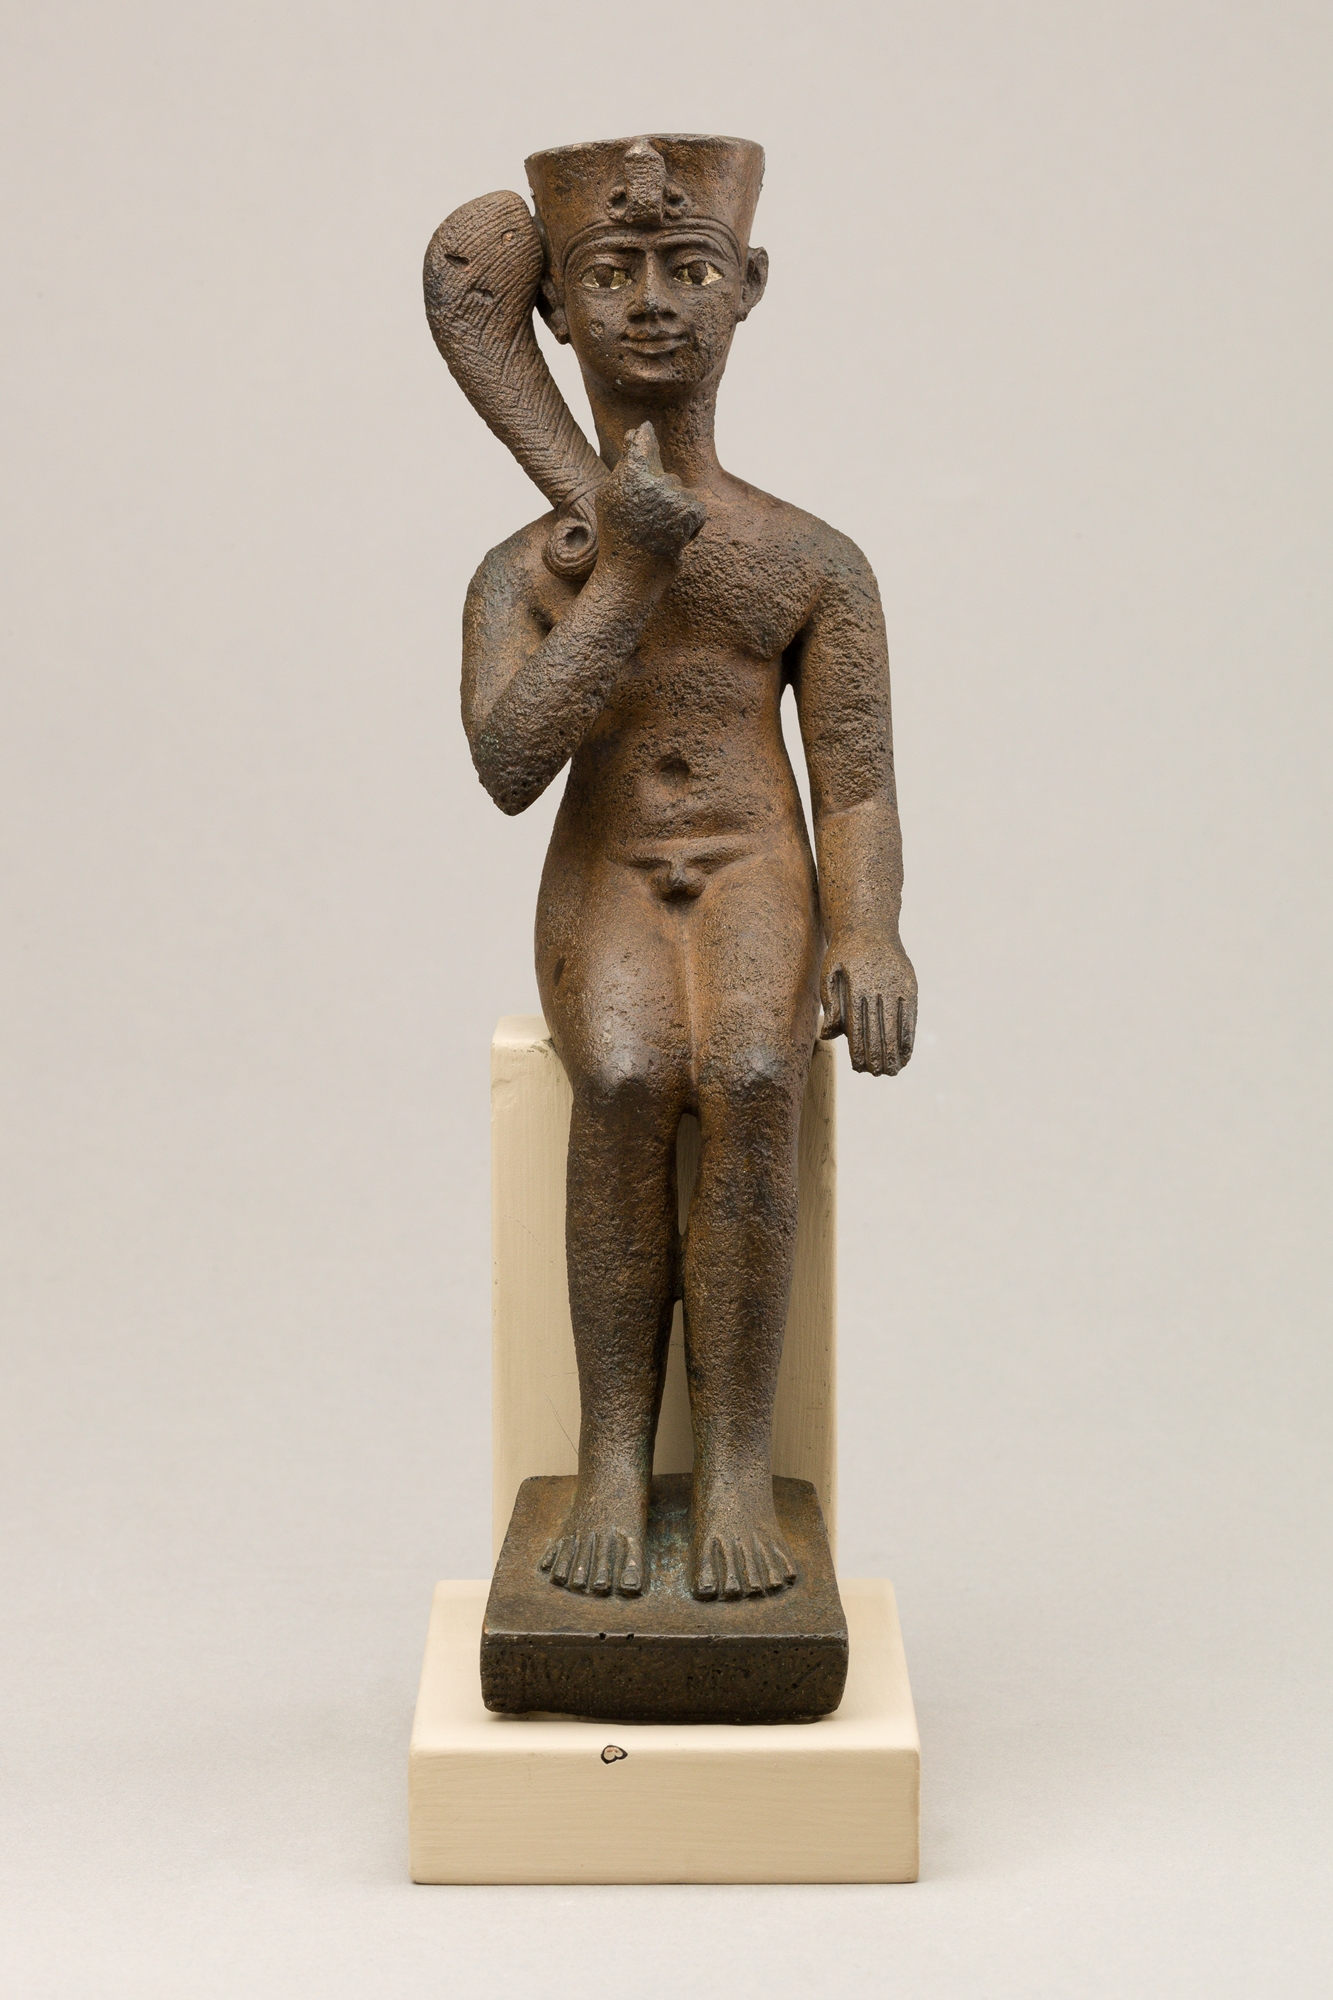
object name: statuette, harpokrates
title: Seated Harpokrates with the crown of Amun, named as "Harpokrates-the-great, the eldest, the first of Amun"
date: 664-630 BCE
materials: metal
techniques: inlay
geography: egypt